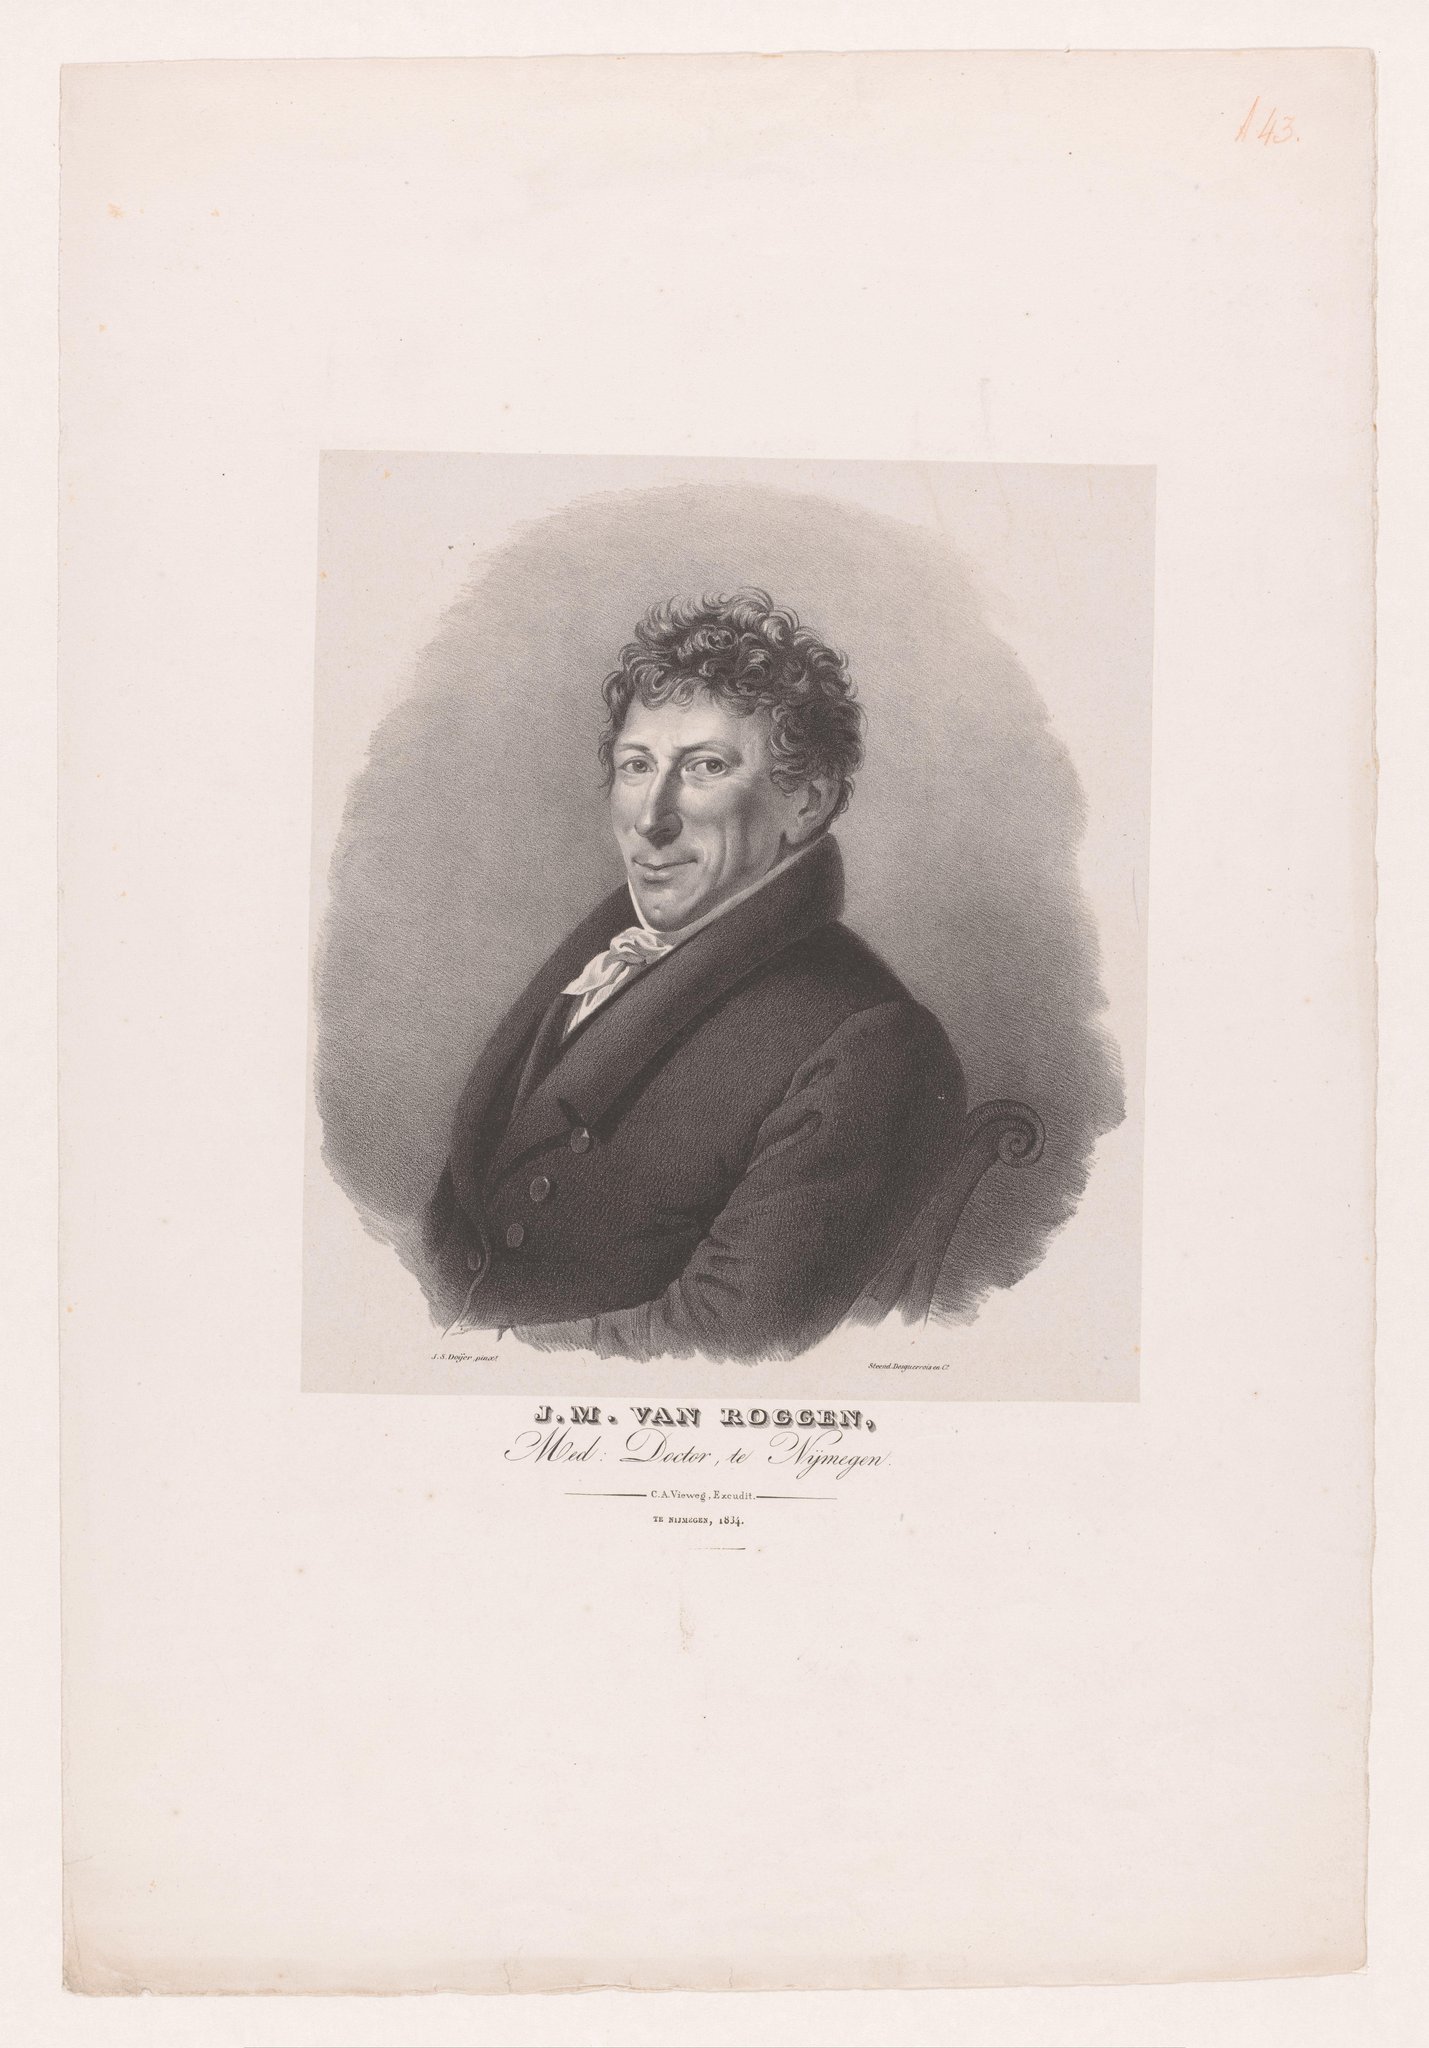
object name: print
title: Portret van J.M. van Roggen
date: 1834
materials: paper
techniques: lithograph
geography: nijmegen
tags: historical persons (+ (full) bust portrait)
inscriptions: collector's mark: Lugt 2233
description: De geportretteerde zit op een stoel naar links gedraaid. Onder het portret zijn naam en beroep.